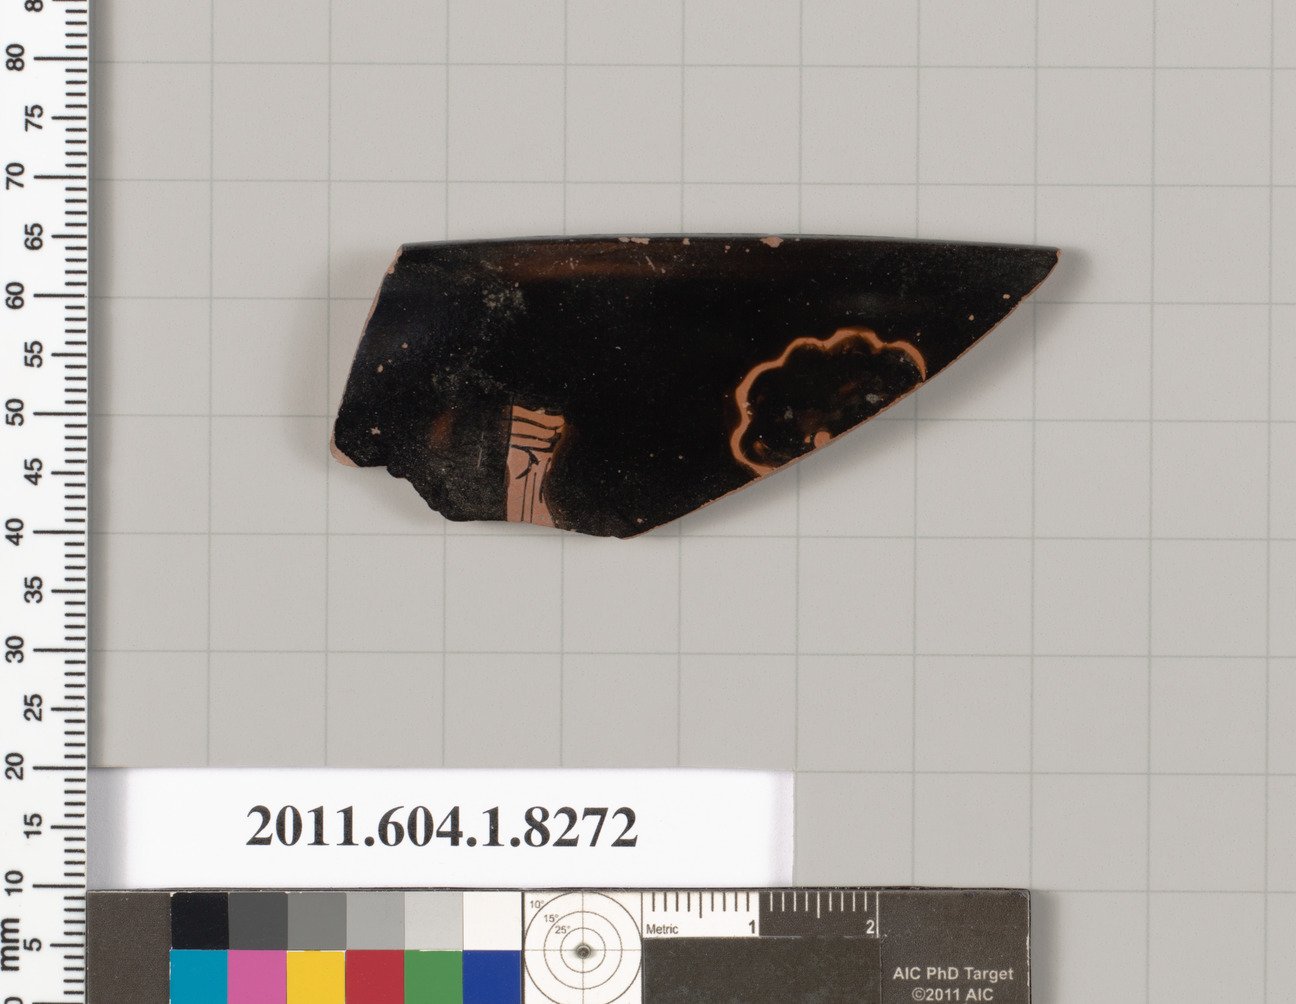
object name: kylix fragment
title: Terracotta rim fragment of a kylix (drinking cup)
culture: greek, attic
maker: painter of london e 106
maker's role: artist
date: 410-400 BCE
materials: terracotta